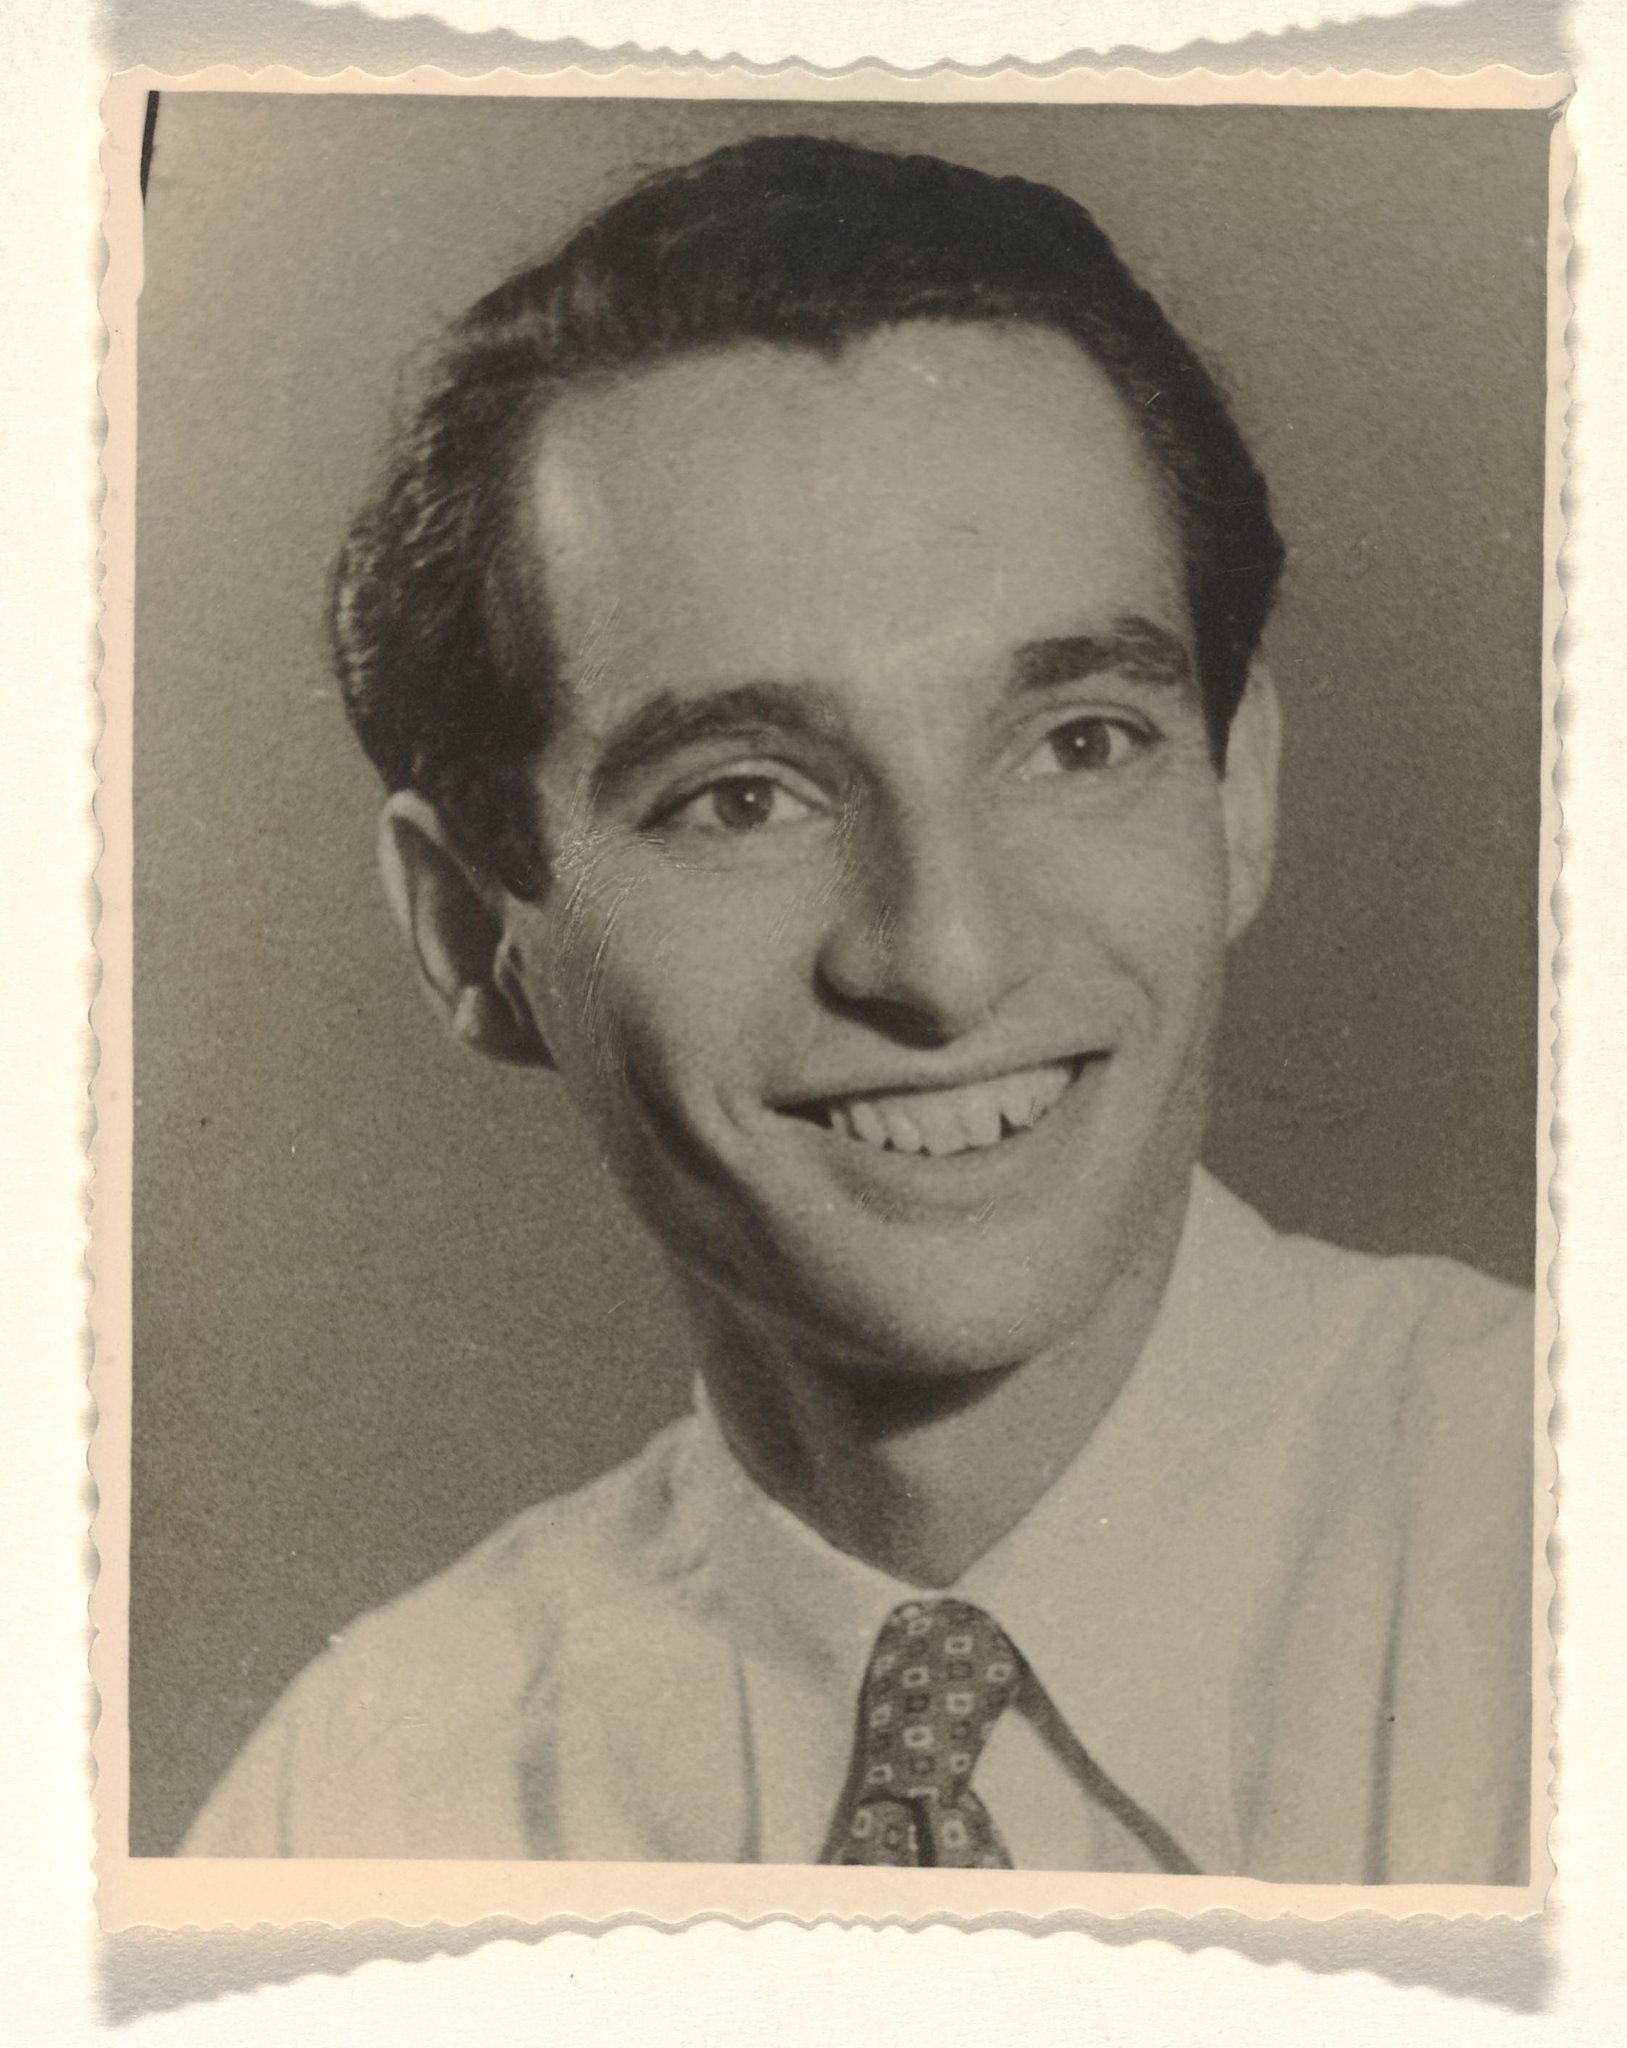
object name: photograph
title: Karl-Heinz Arndtheim, de tweede echtgenoot van Isabel Wachenheimer, lachend met het hoofd naar rechts, in Israël tussen 1949 en 1955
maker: Anonymous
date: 1949-1955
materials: photographic support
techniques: gelatin silver print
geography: israel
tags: karl-heinz arndtheim, israël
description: Karl-Heinz Arndtheim, de tweede echtgenoot van Isabel Wachenheimer, lachend met het hoofd naar rechts.